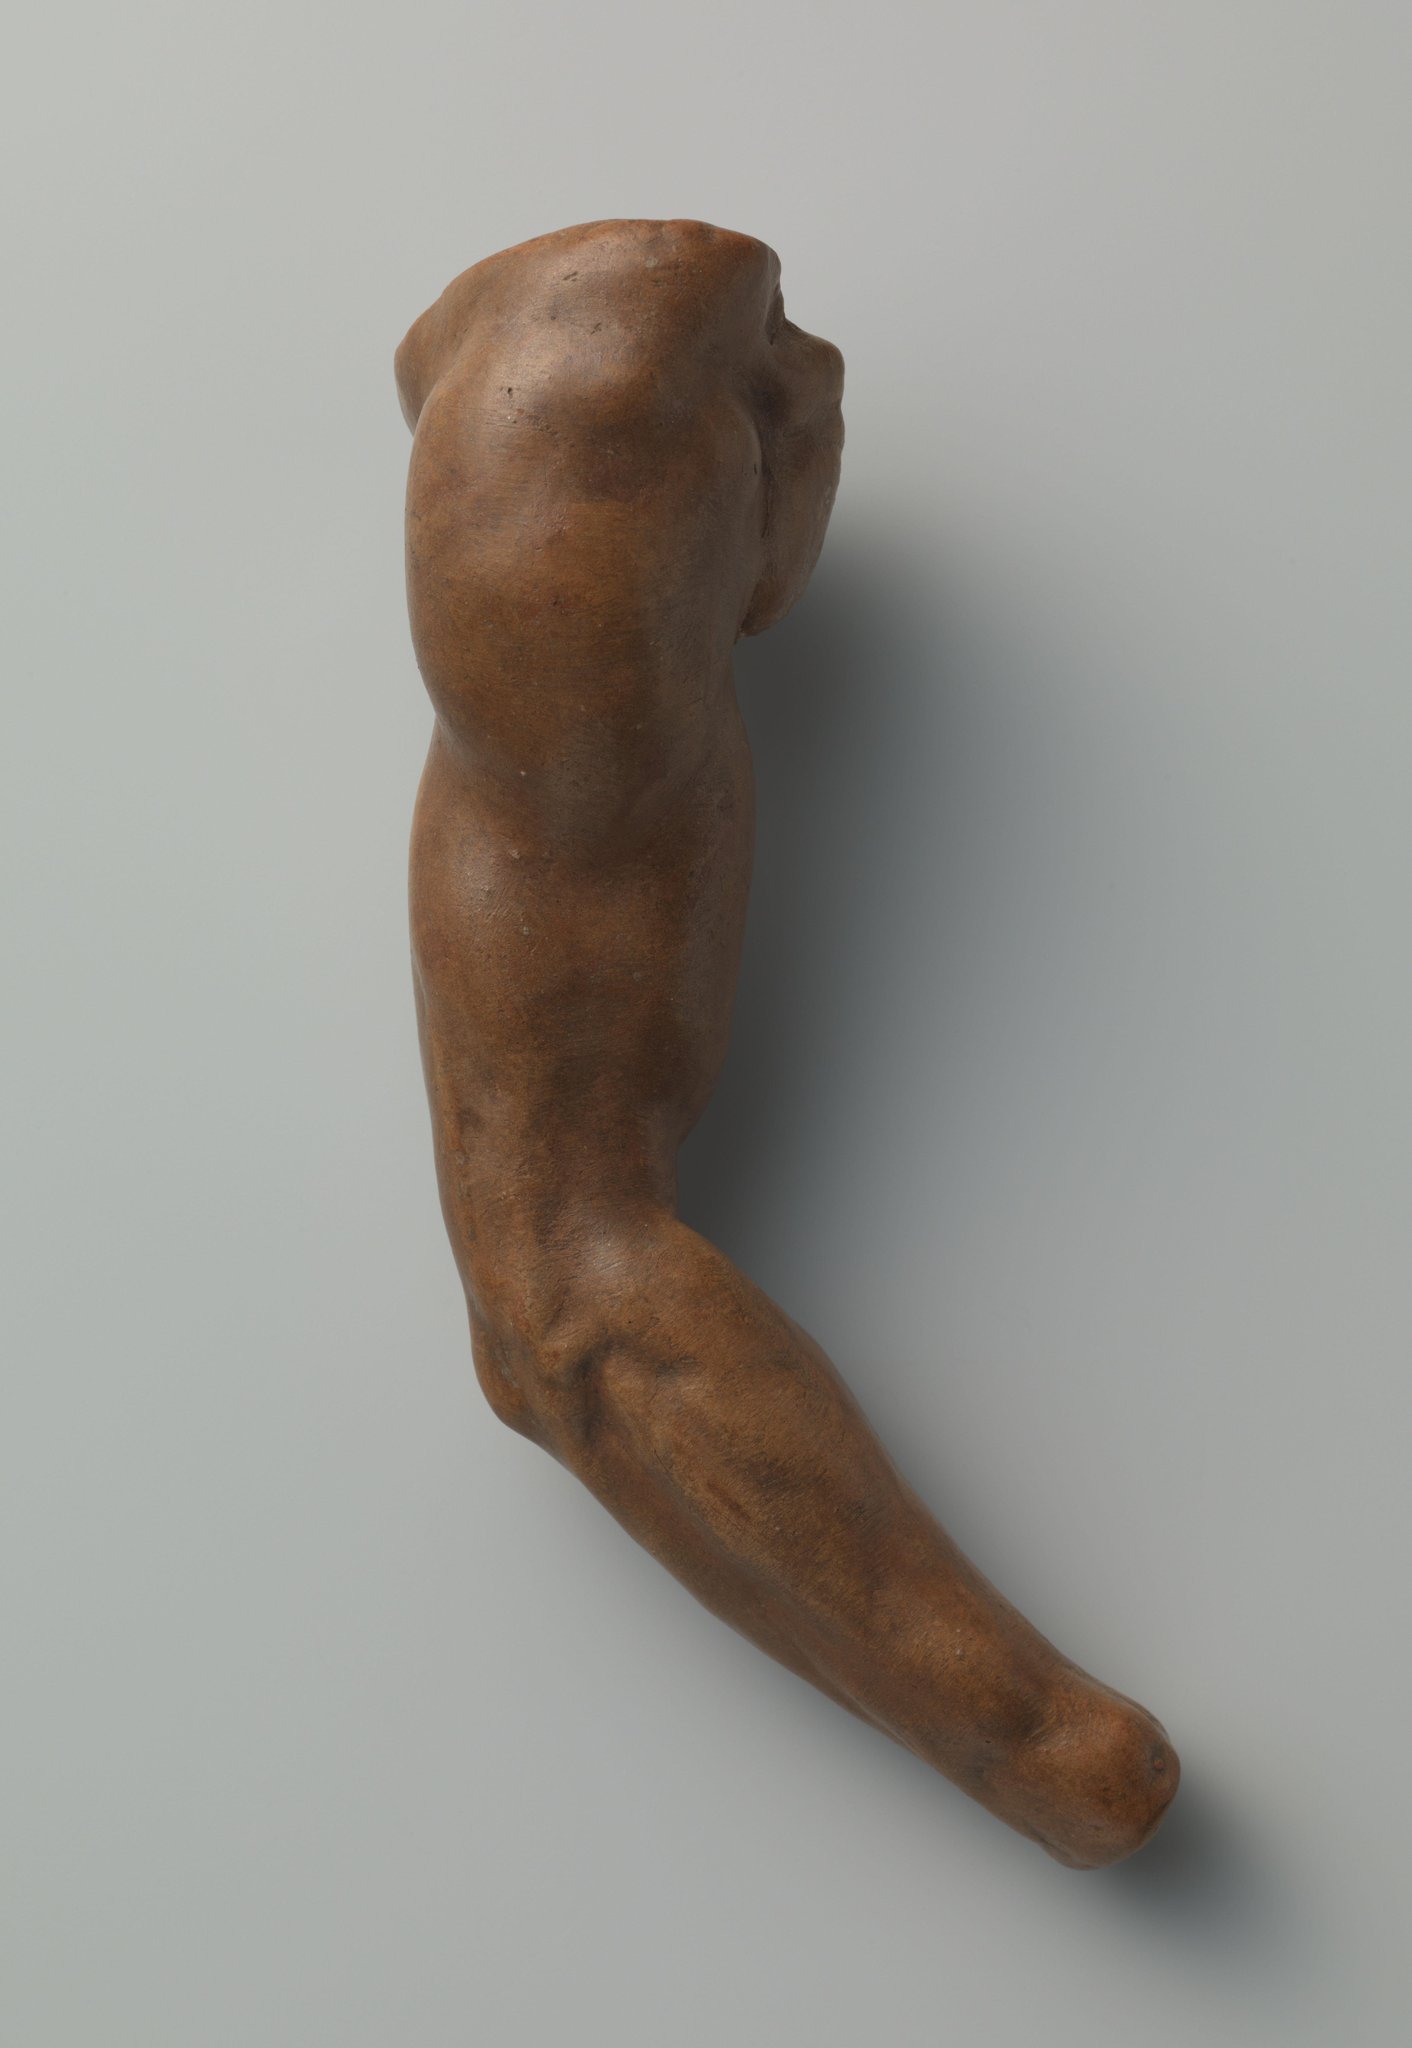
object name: model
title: Study Models of Parts of the Body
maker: johan gregor van der schardt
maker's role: sculptor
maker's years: 1530-1581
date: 1560-1570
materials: terracotta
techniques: casting, molding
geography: florence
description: This group of small models of parts of the body is carefully copied after famous sculptures, in particular by Michelangelo, in Florence and Rome. They came from the workshop of the Nijmegen sculptor Johan Gregor van der Schardt, who had a successful career in Italy, Nuremberg, and Copenhagen. They are extremely rare examples of the, in part autograph, study material of a 16th-century sculptor.